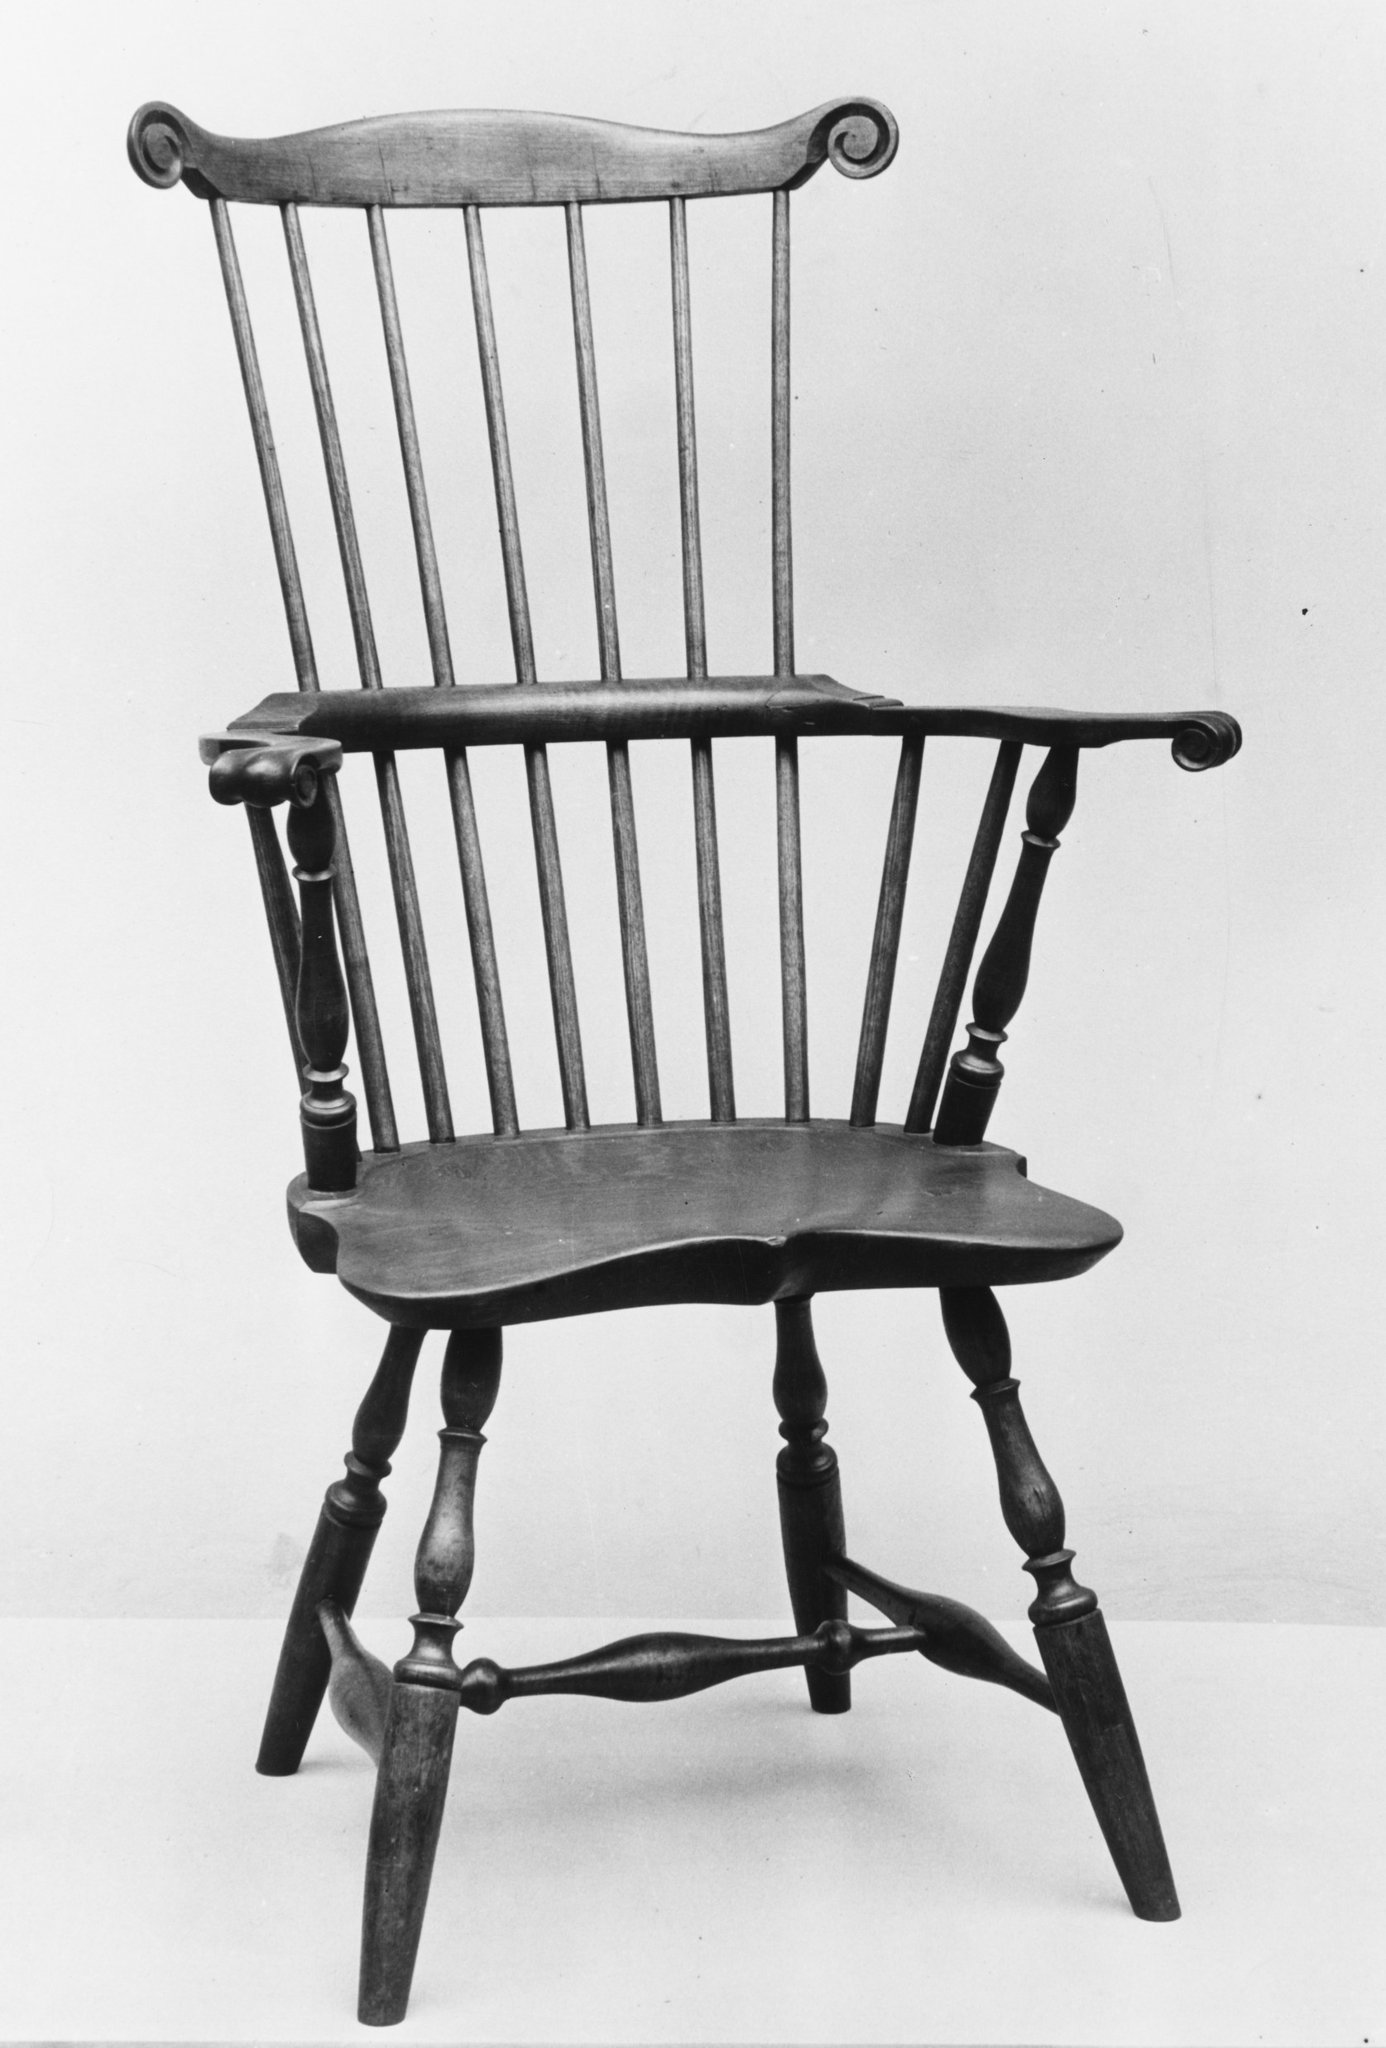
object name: armchair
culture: american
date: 1750-1800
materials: wood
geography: united states